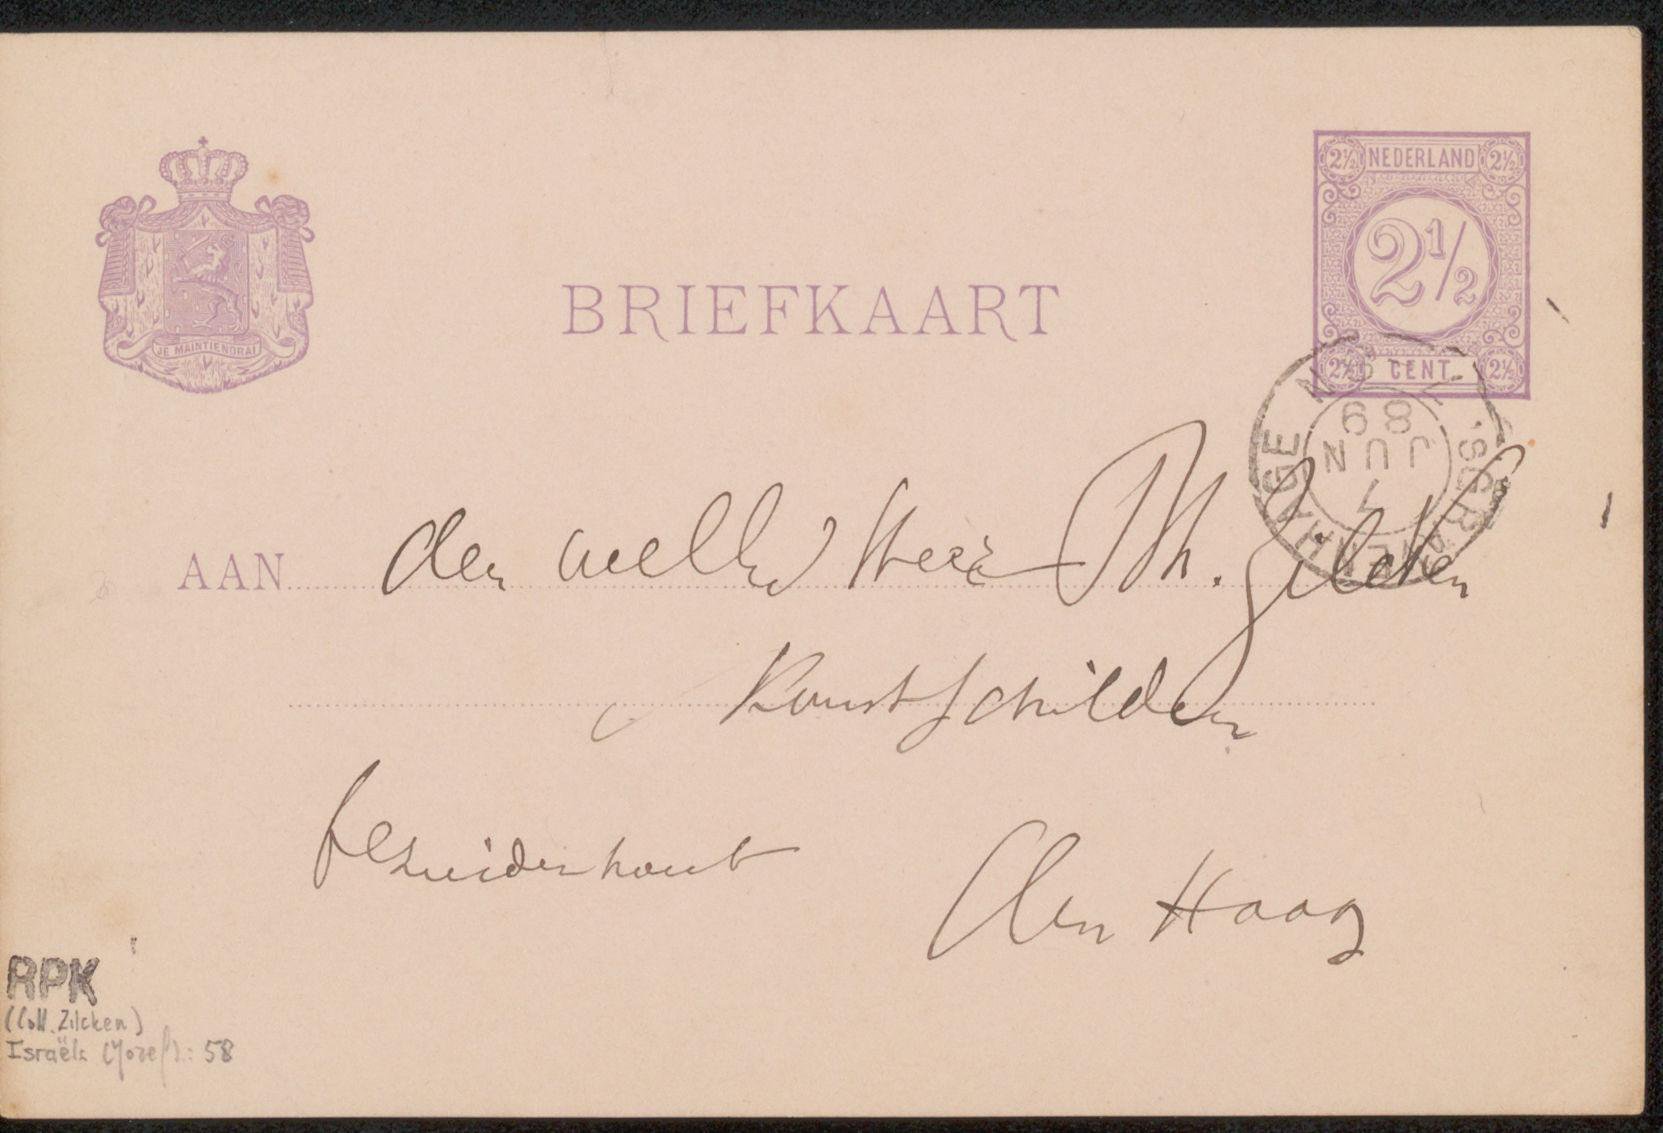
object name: postcard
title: Briefkaart aan Philip Zilcken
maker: jozef israëls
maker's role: draughtsman, painter, print maker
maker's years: 1824-1911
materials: cardboard, ink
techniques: pen, writing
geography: the hague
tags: philip zilcken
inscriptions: collector's mark: ‘RPK’